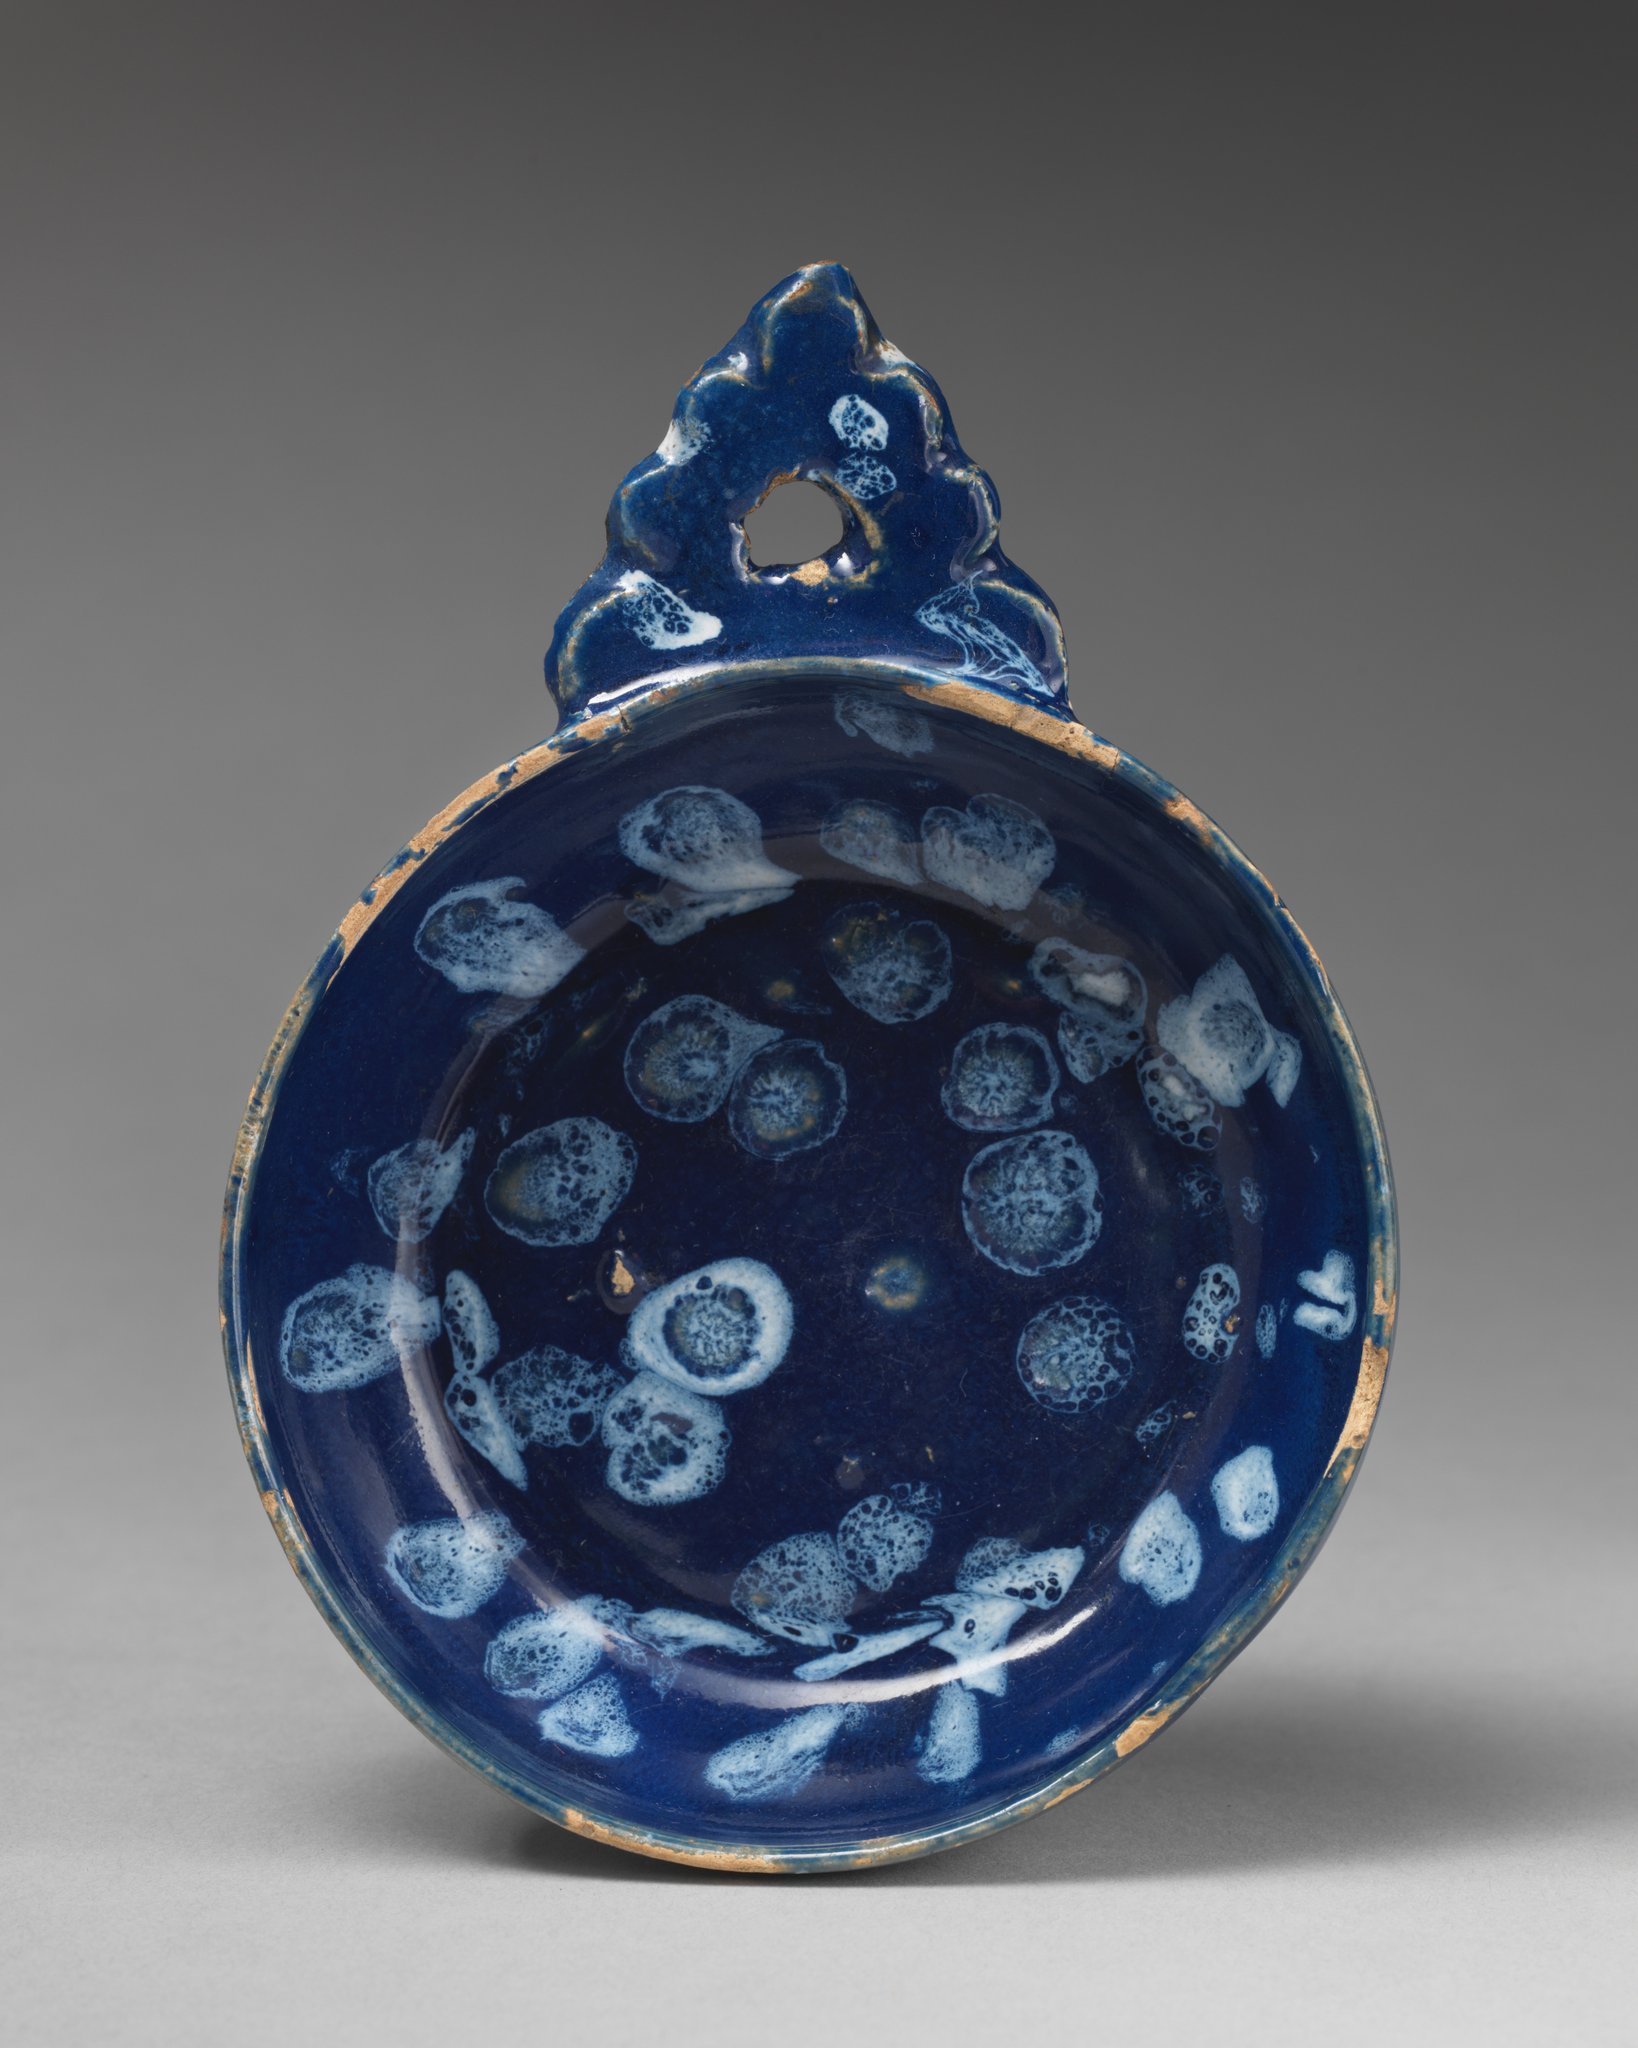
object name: bowl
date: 1651-1700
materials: earthenware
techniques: glazing